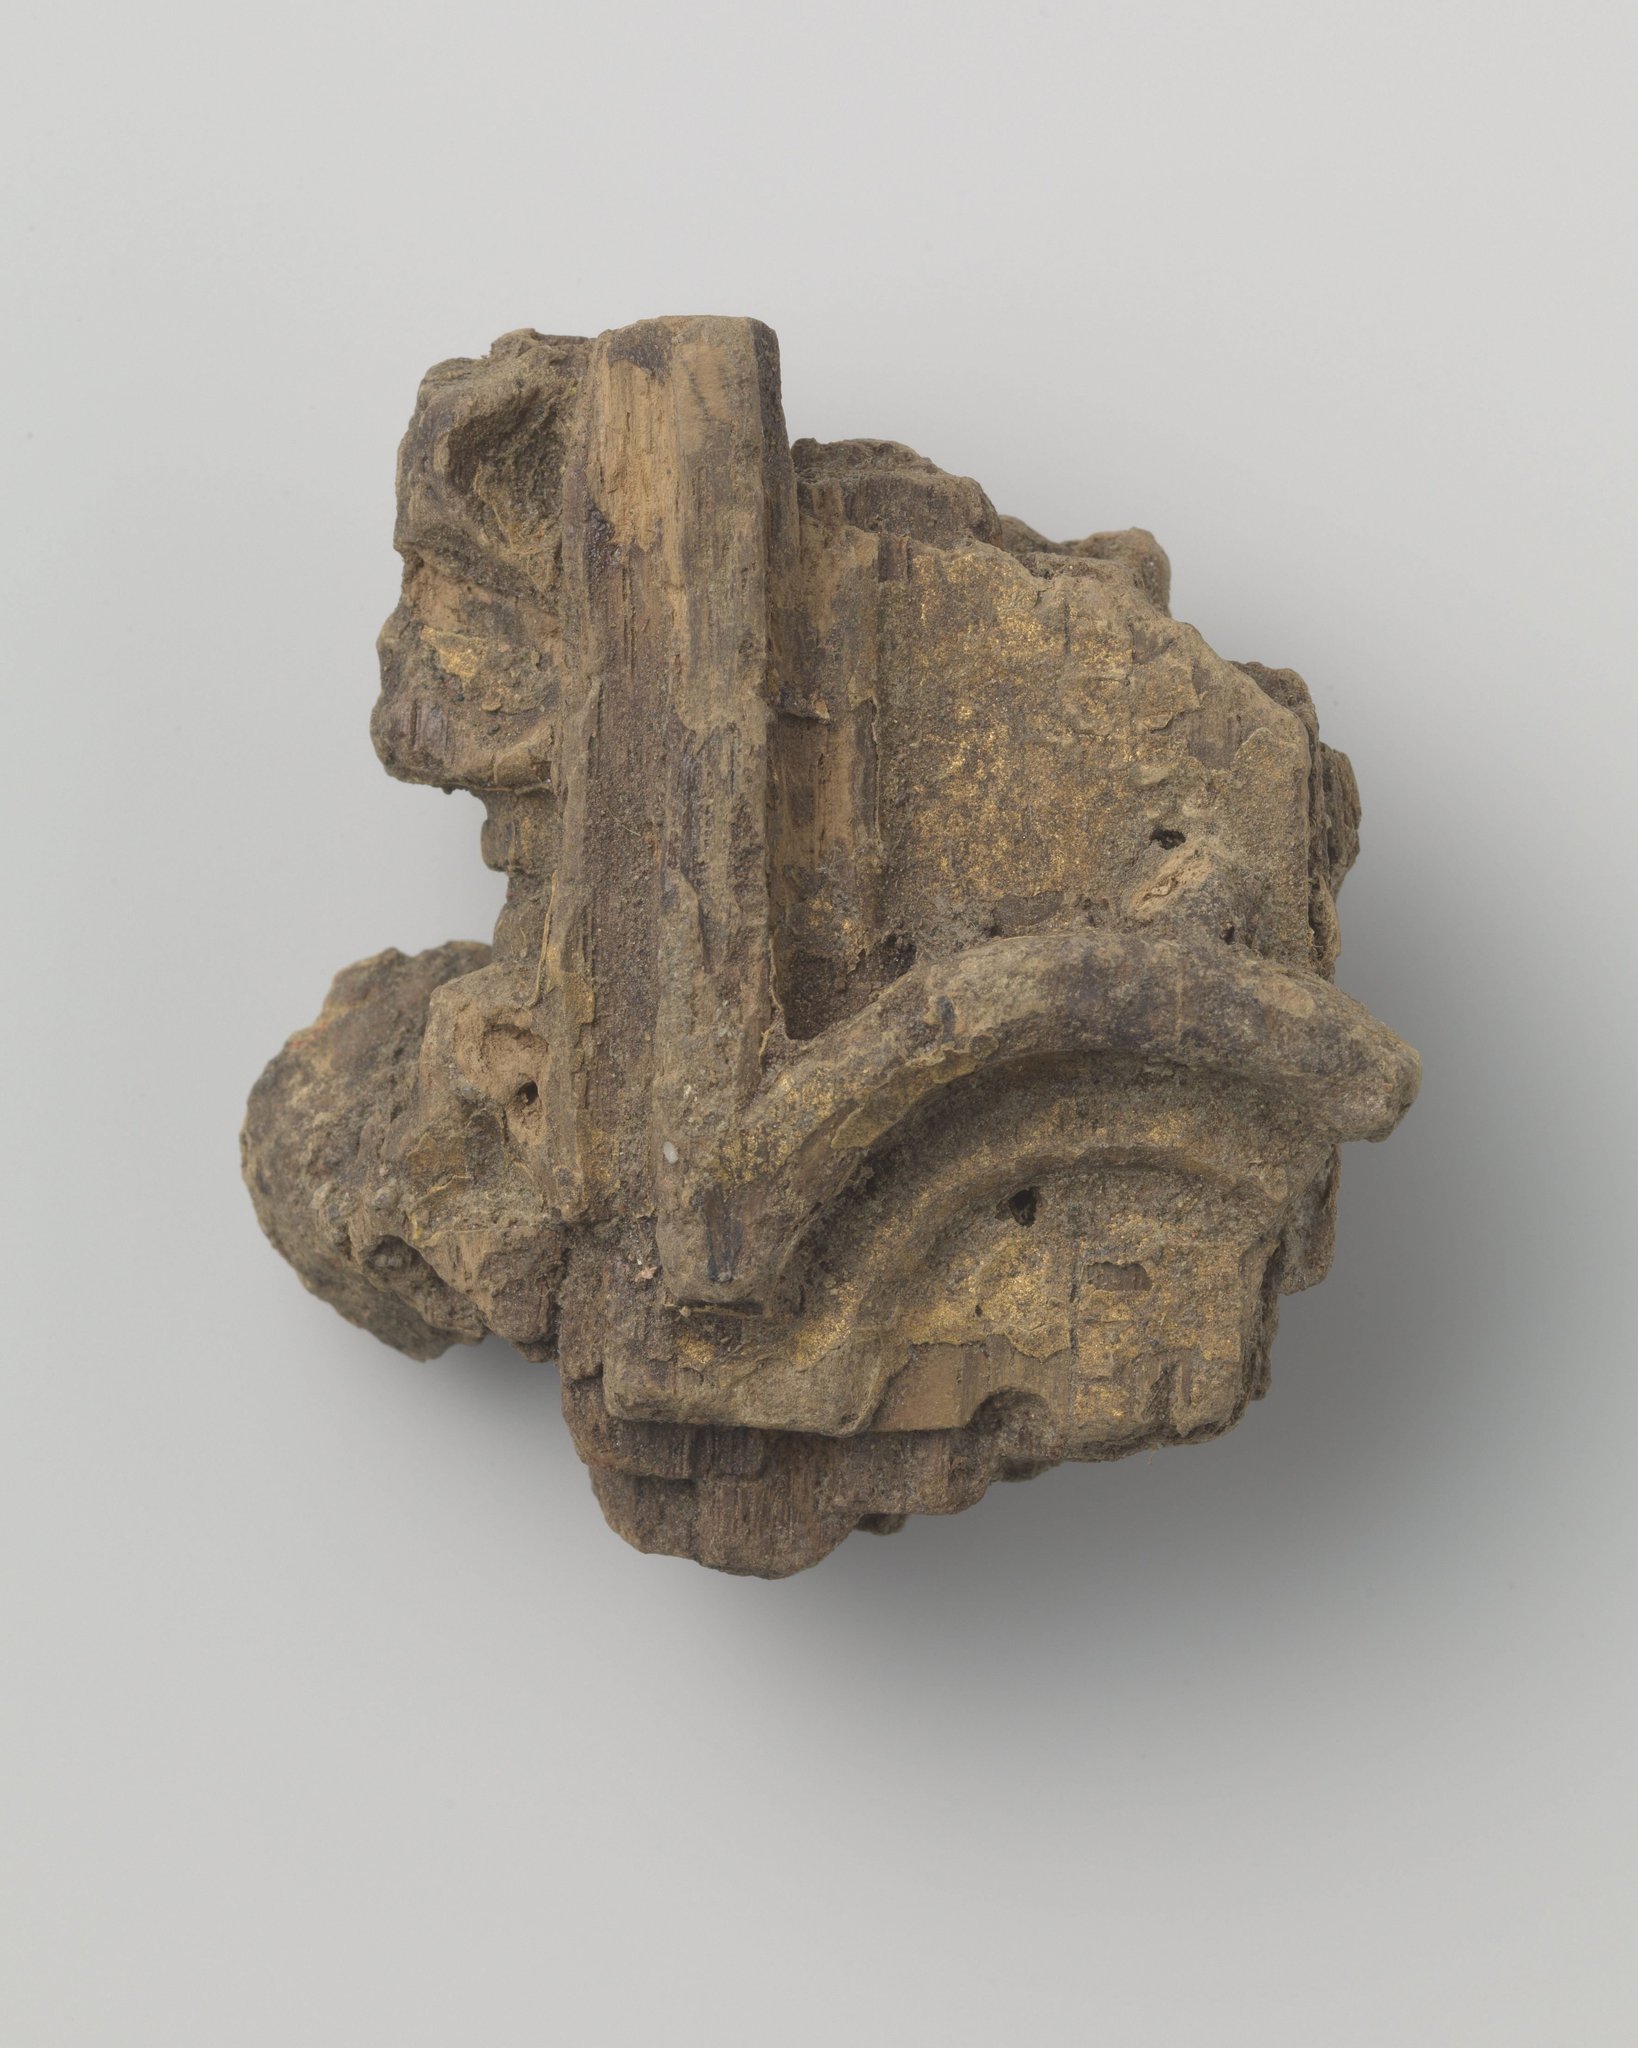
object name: fragment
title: Fragment; (mogelijk) behorend tot het retabel van Soest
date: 1475-1499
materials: wood